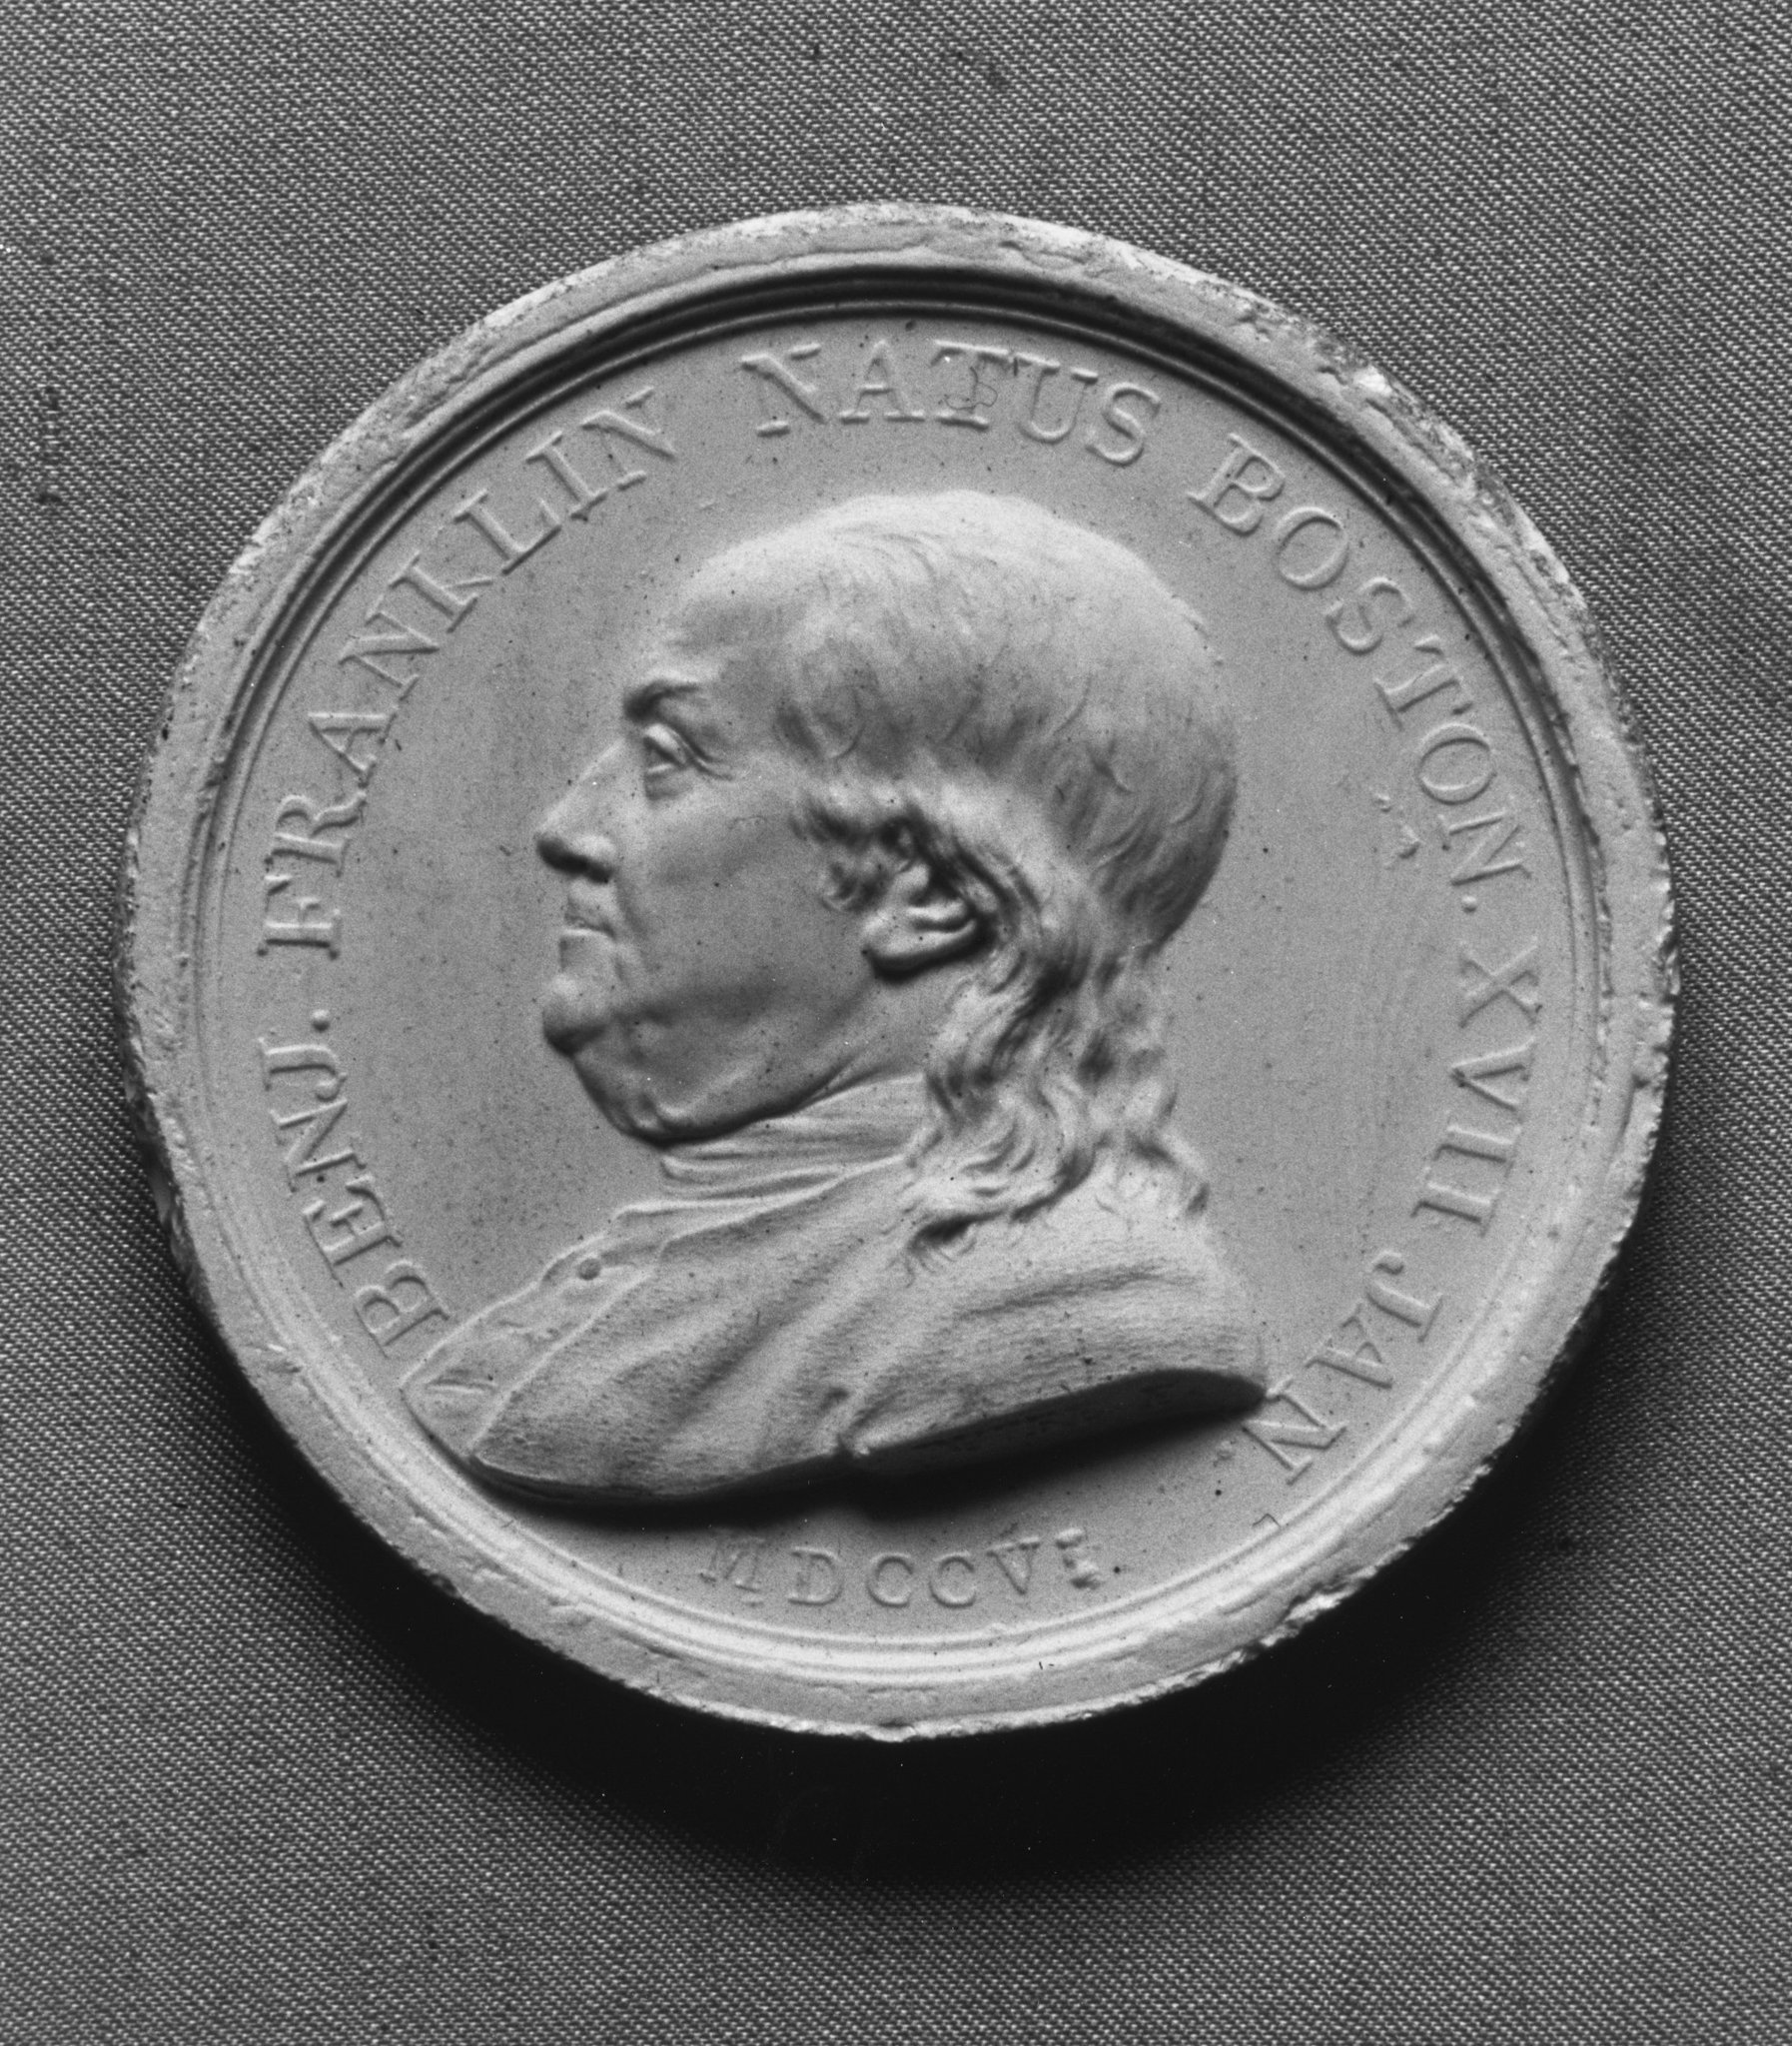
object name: plaque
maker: james tassie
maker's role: artist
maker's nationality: british, scottish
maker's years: 1735-1799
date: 1776-1830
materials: glass, paste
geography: england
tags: benjamin franklin,profiles